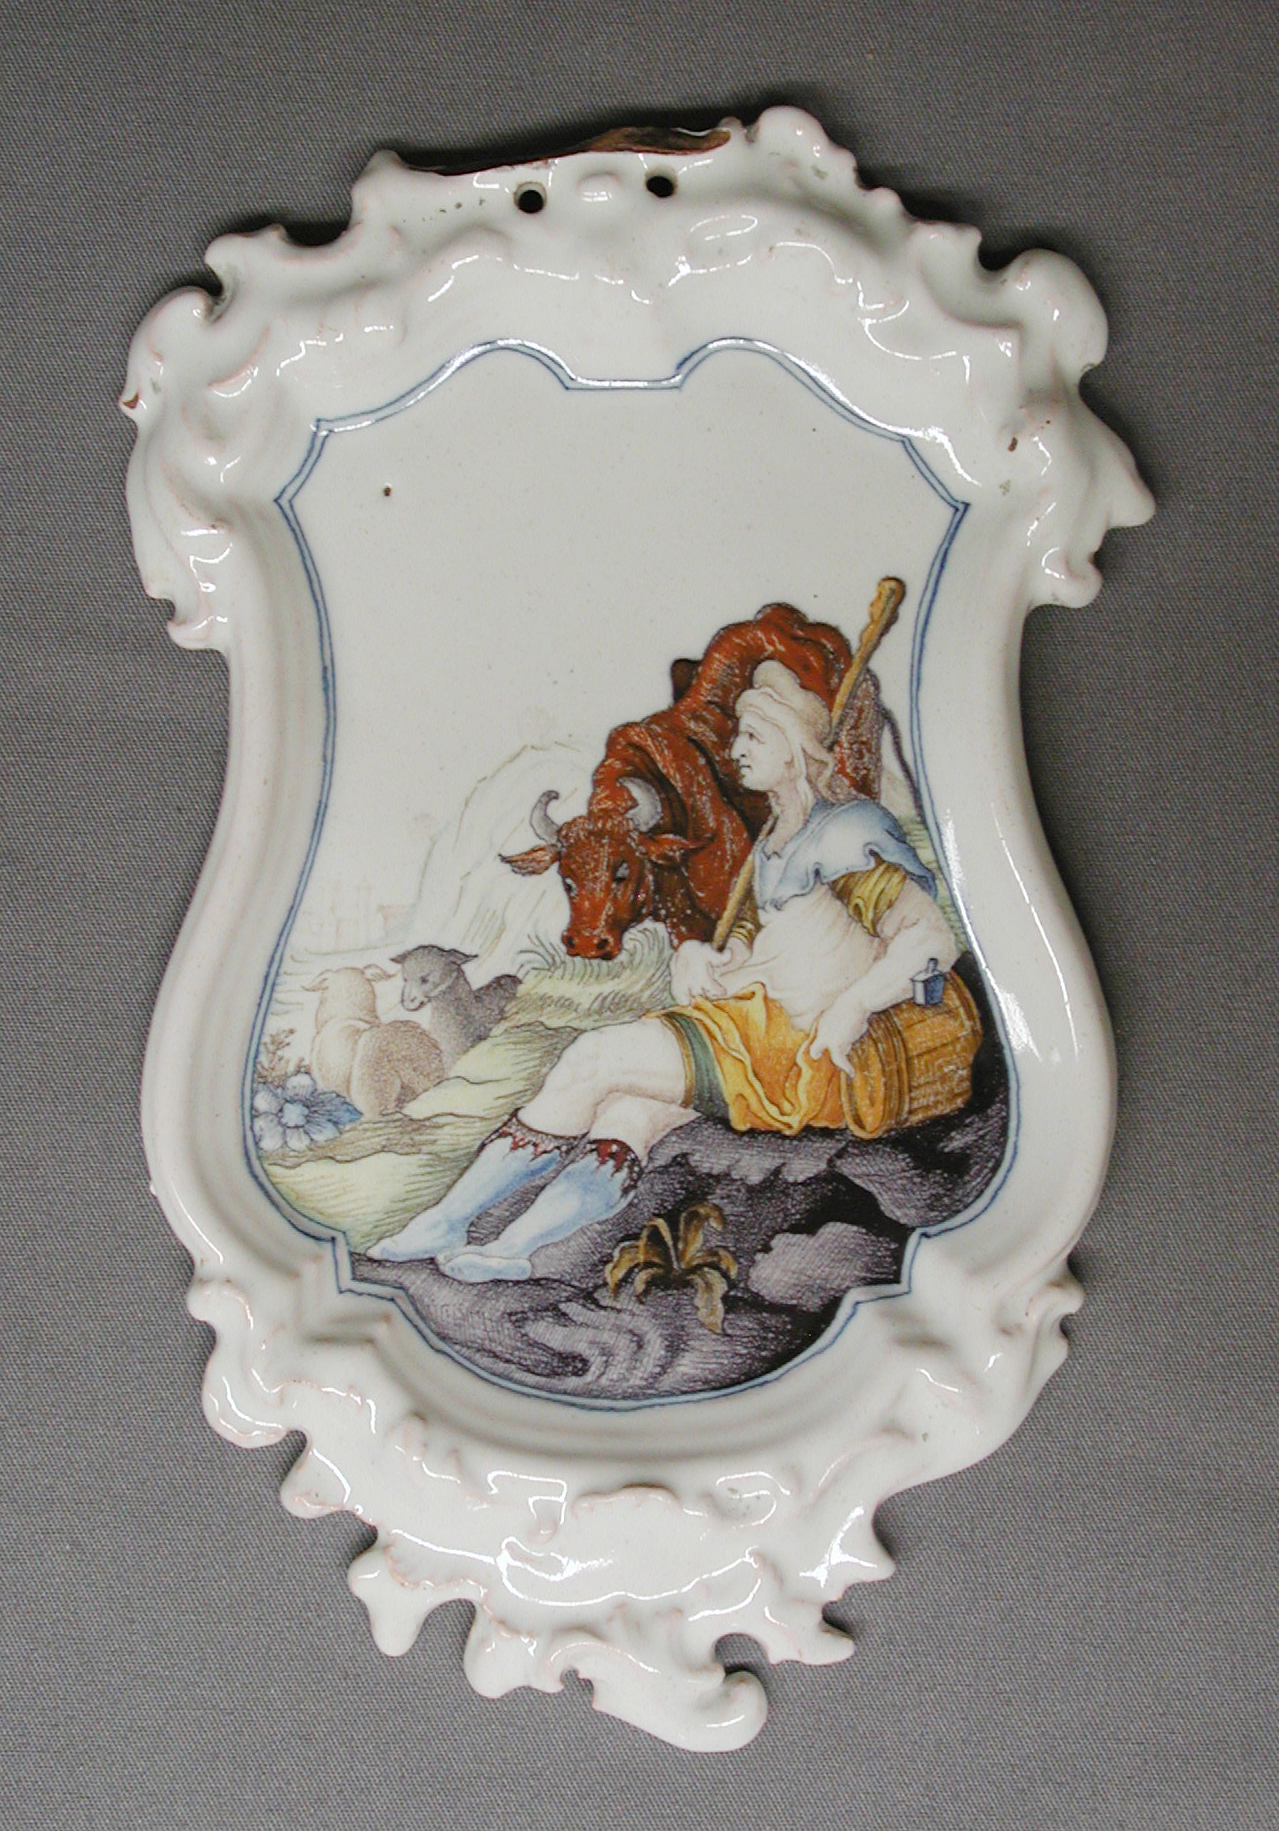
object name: plaque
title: Plaque (one of a pair)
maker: alcora manufactory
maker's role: factory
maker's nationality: spanish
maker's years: 1727-1895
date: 1755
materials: earthenware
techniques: enamel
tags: human figures,cows